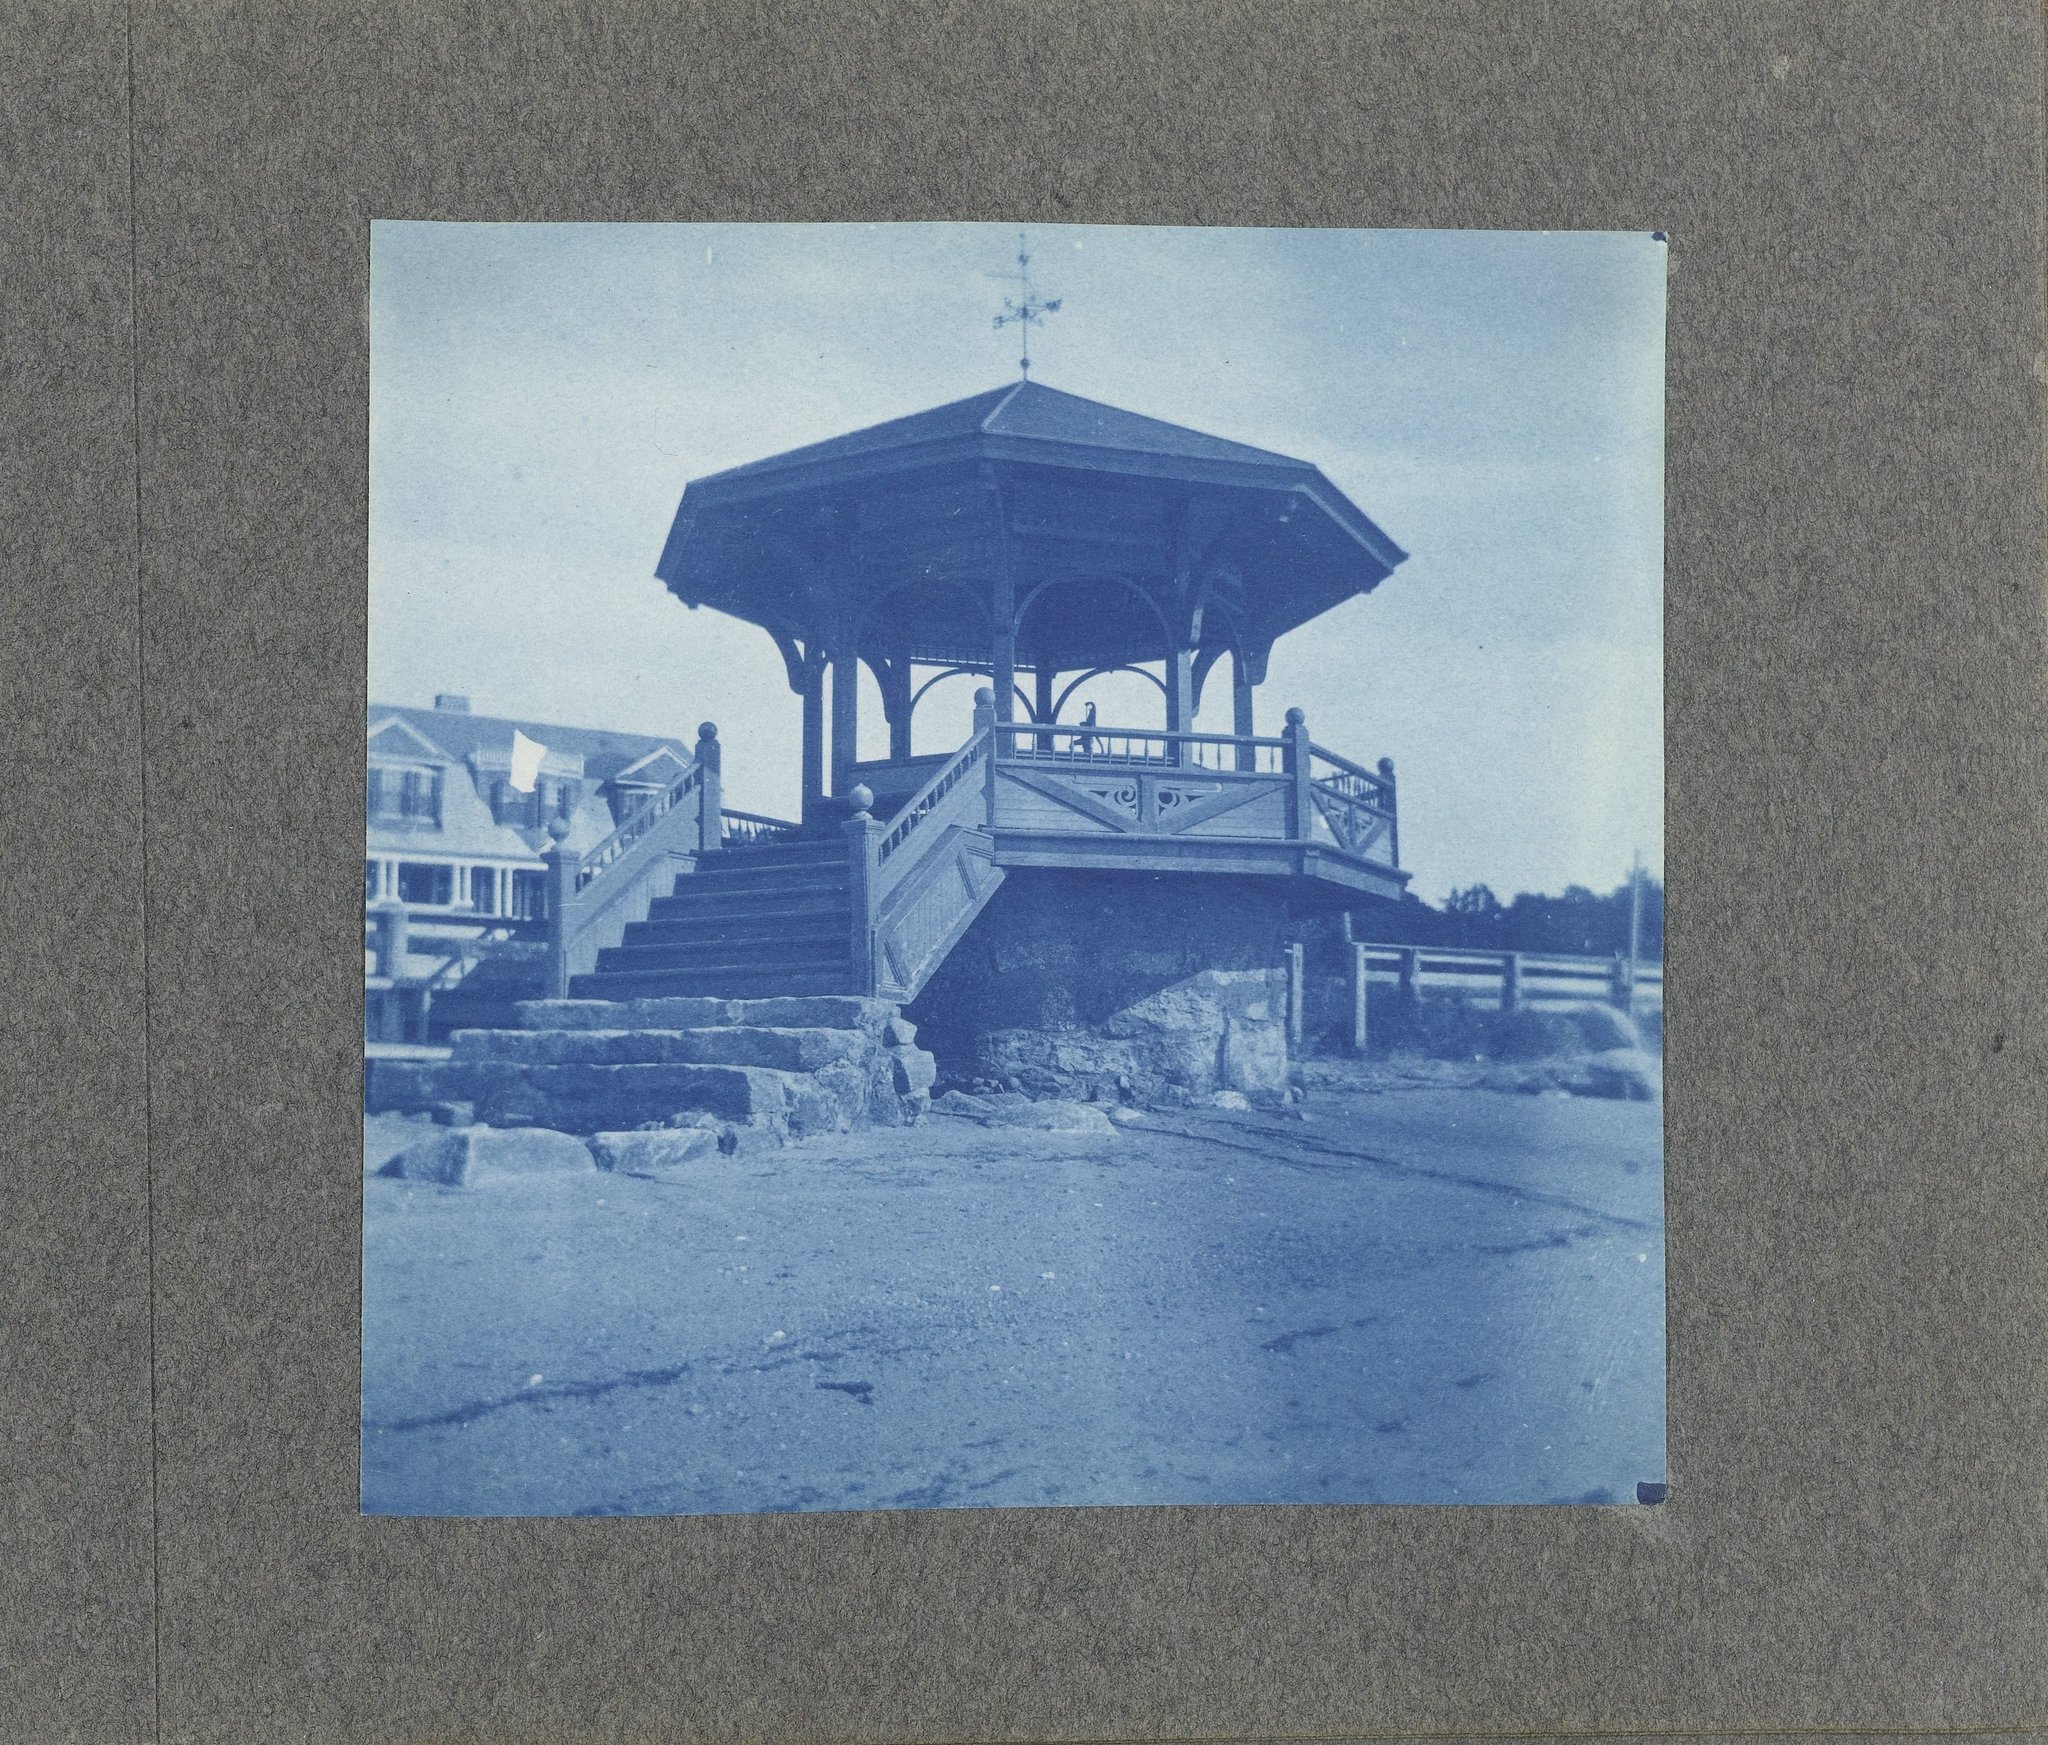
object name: photograph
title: Houten muziekkoepel met trap en windrichtingwijzer, Verenigde Staten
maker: Anonymous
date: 1900-1920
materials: paper, photographic support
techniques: cyanotype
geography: united states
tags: bandstand, united states of america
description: Onderdeel van Fotoalbum met 53 cyanotypieën van kinderen, paarden, huizen, boten en strandtaferelen in de Verenigde Staten.